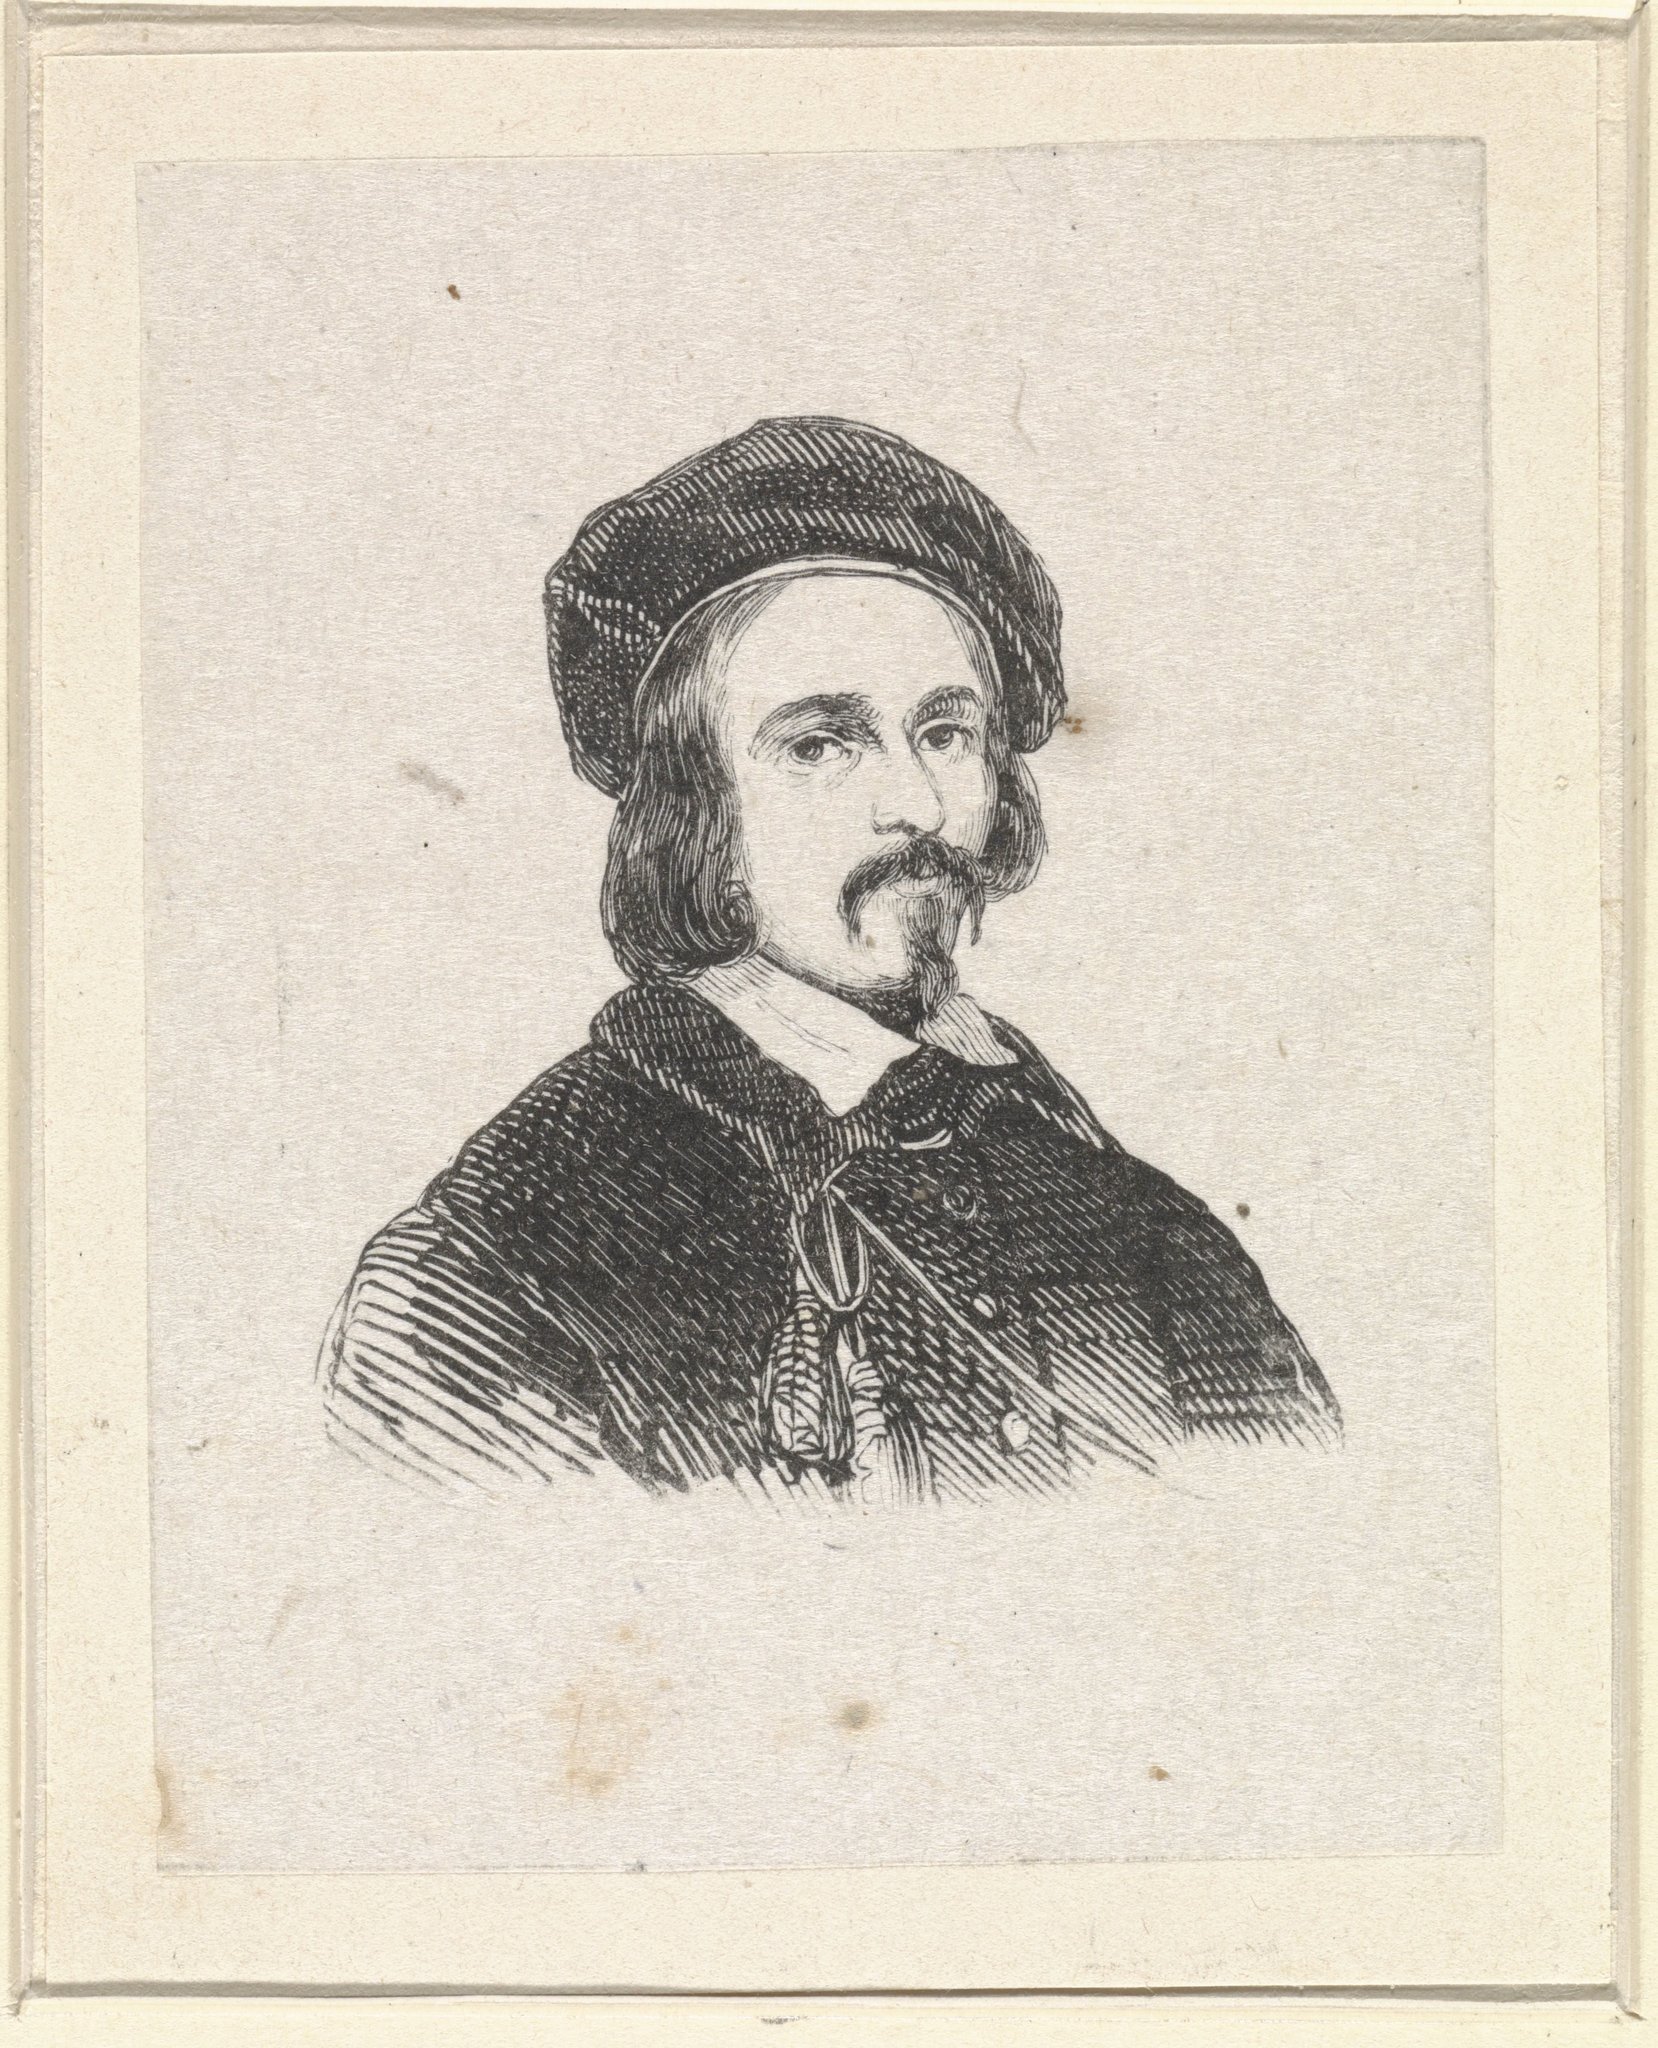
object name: print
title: Portret van Jozef Geefs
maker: Anonymous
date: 1840-1842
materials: paper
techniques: engraving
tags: brussels, sculptor, jozef geefs, historical persons, portrait, self-portrait of painter, portrait, self-portrait of artist, portrait, self-portrait of draughtsman